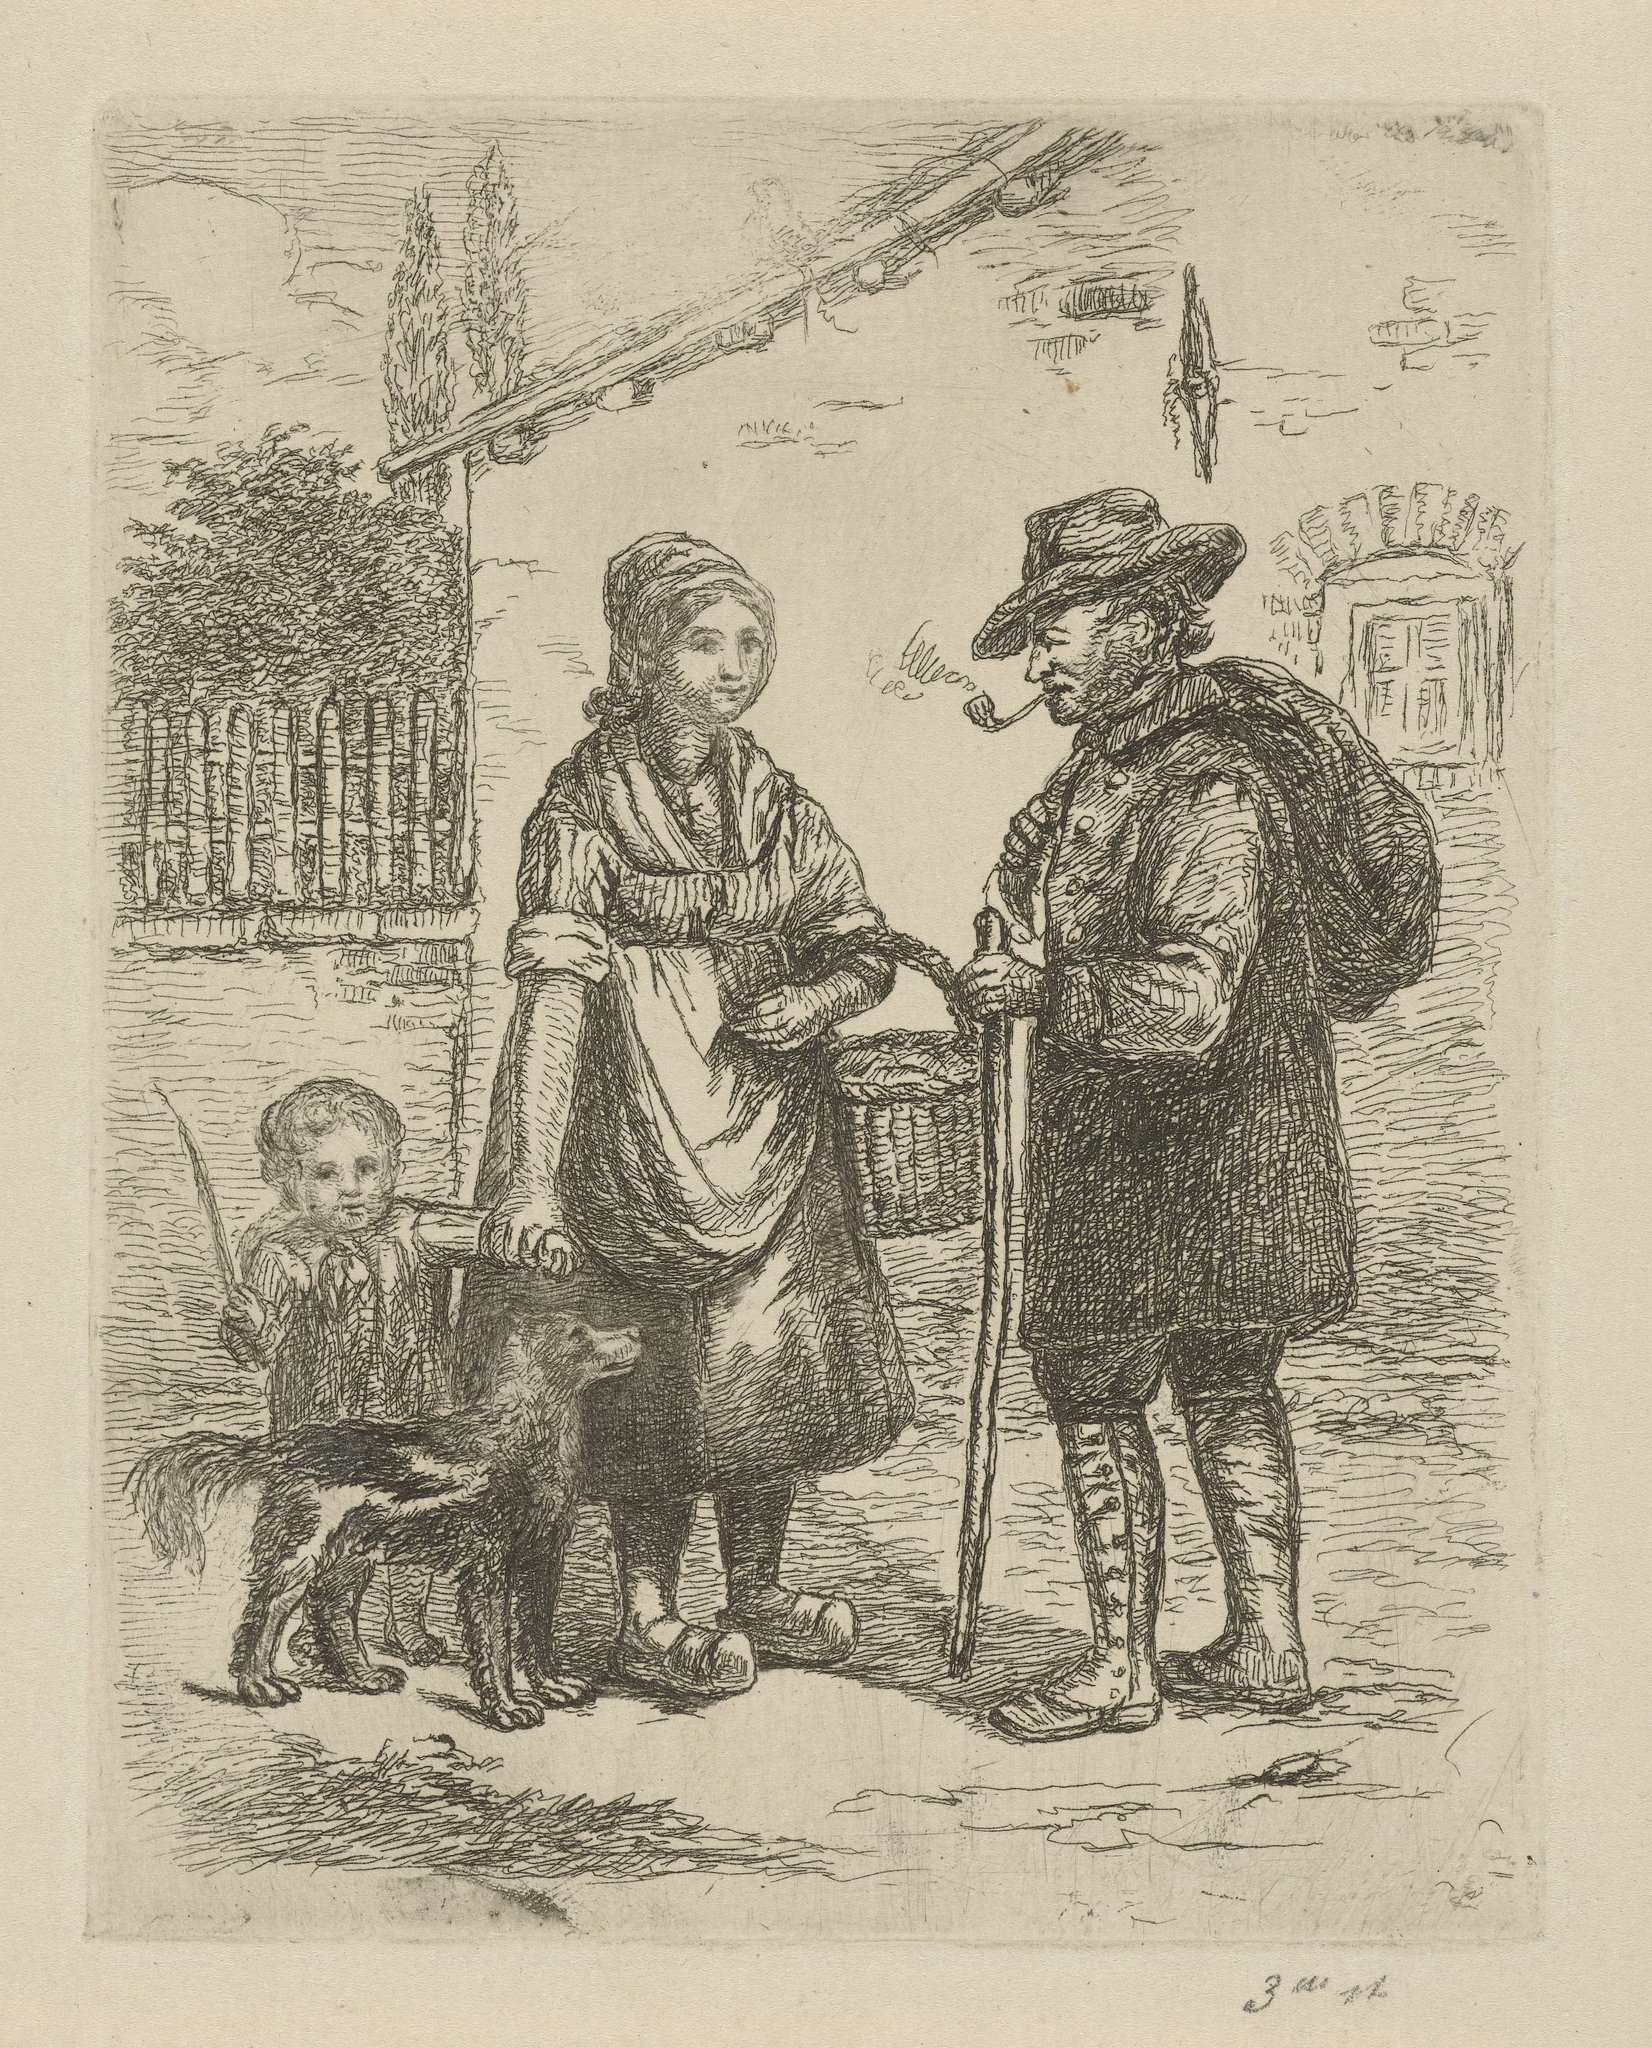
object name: print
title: Boer en boerin bij een hoeve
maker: david van der kellen (1804-1879)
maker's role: die cutter, draughtsman, print maker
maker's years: 1804-1879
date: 1814-1878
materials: paper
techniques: etching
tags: pipe ~ tobacco, farmers - aa - female farmer, farmer's wife, dog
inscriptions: inscription: ‘3de staat’, collector's mark: Lugt 2228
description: Voor een huis staan een pijprokende man met een wandelstok en hoed en een boerin met een kind aan haar hand. De boerin draagt een mand. Naast hen een hondje en op het dak van het huis zitten twee tortelduiven.